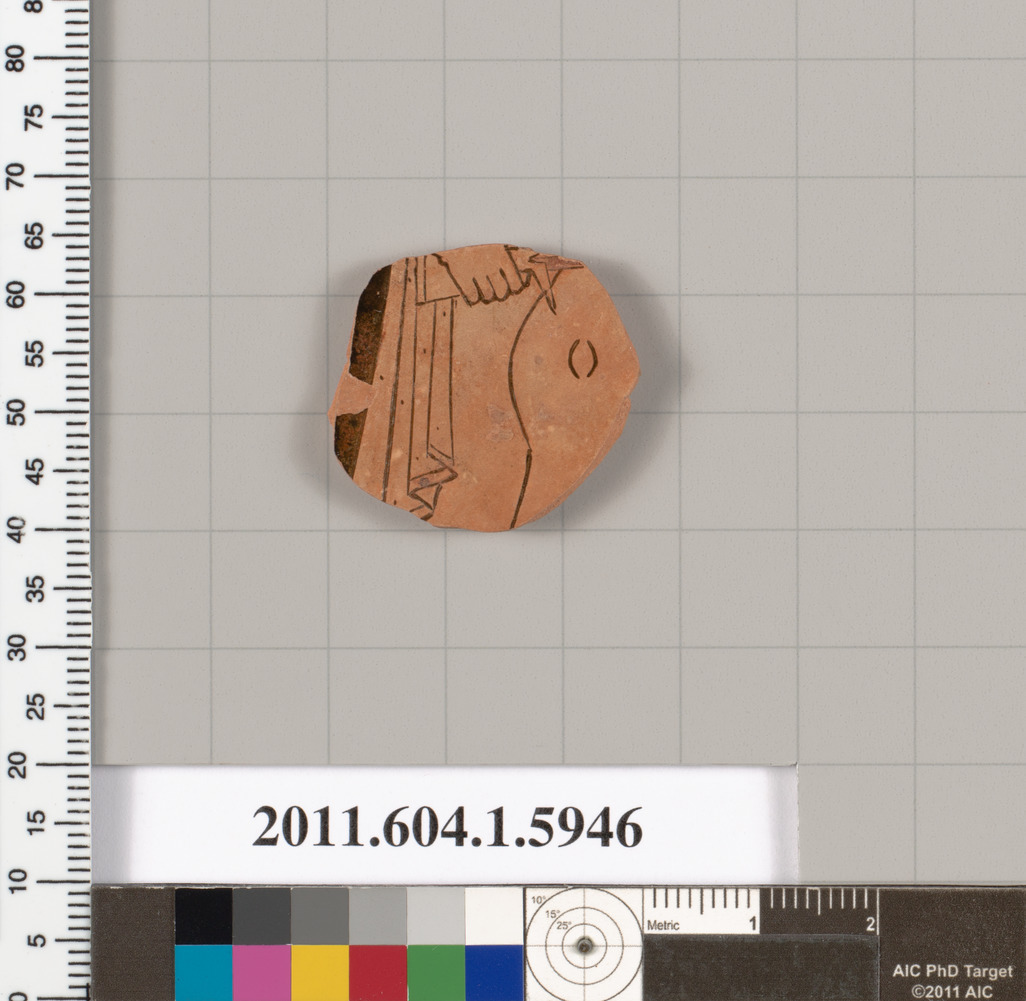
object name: kylix fragment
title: Terracotta fragment of a kylix (drinking cup)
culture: greek, attic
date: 433-567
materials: terracotta